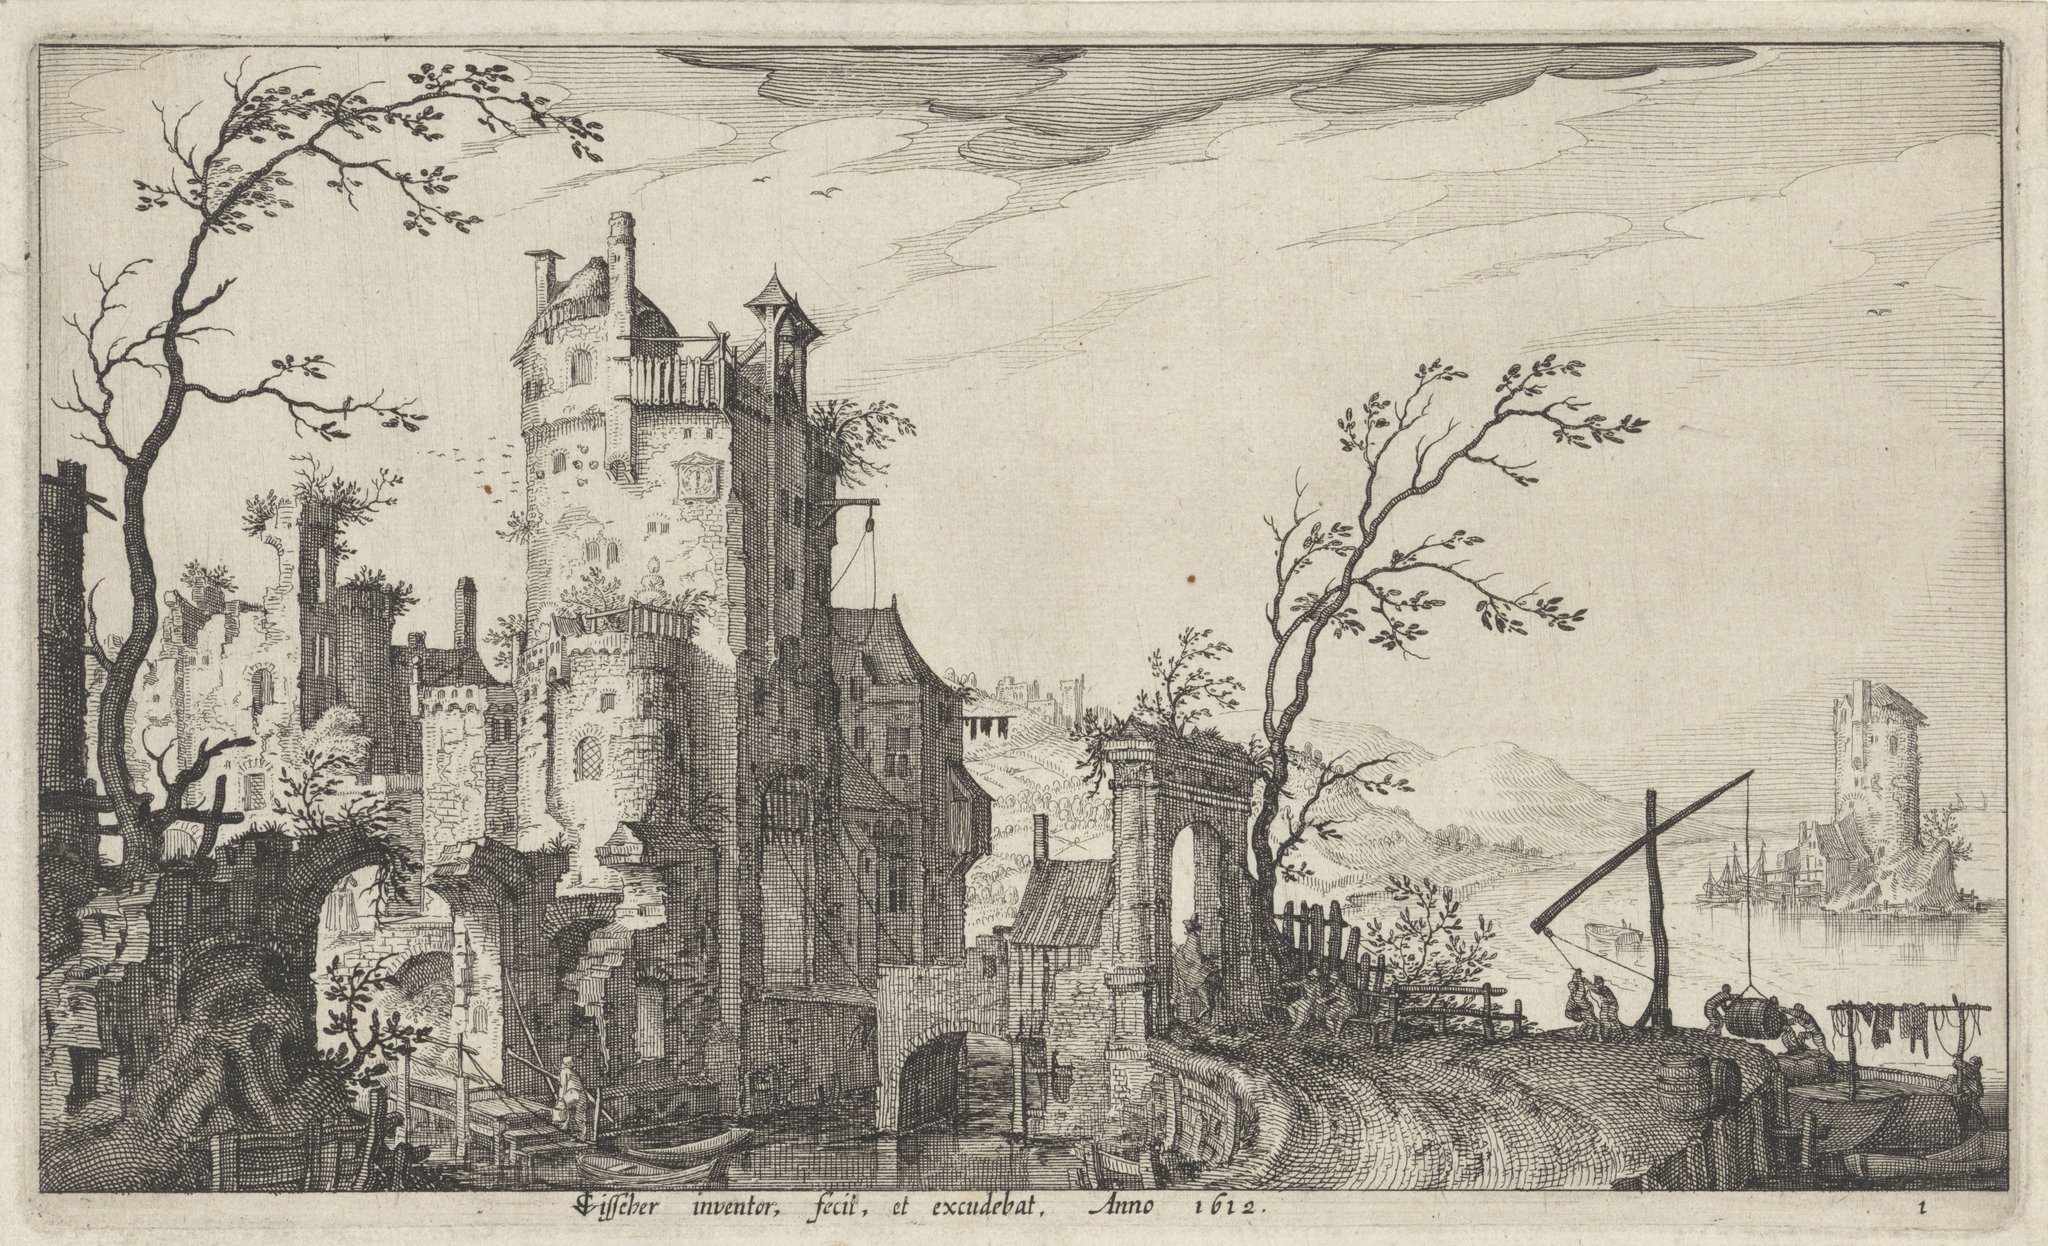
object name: print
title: Ruïneuze stadspoort aan het water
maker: claes jansz. visscher (ii)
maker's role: draughtsman, print maker, publisher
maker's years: 1586-1652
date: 1612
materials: paper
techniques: engraving, etching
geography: amsterdam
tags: river, landscape with tower or castle, city-gate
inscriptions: collector's mark: Lugt 2765, collector's mark: Lugt 2228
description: Gezicht op een heuvellandschap met op de voorgrond een ruïneuze stadspoort. Rechts op de achtergrond is in de rivier een eilandje met een toren te zien.